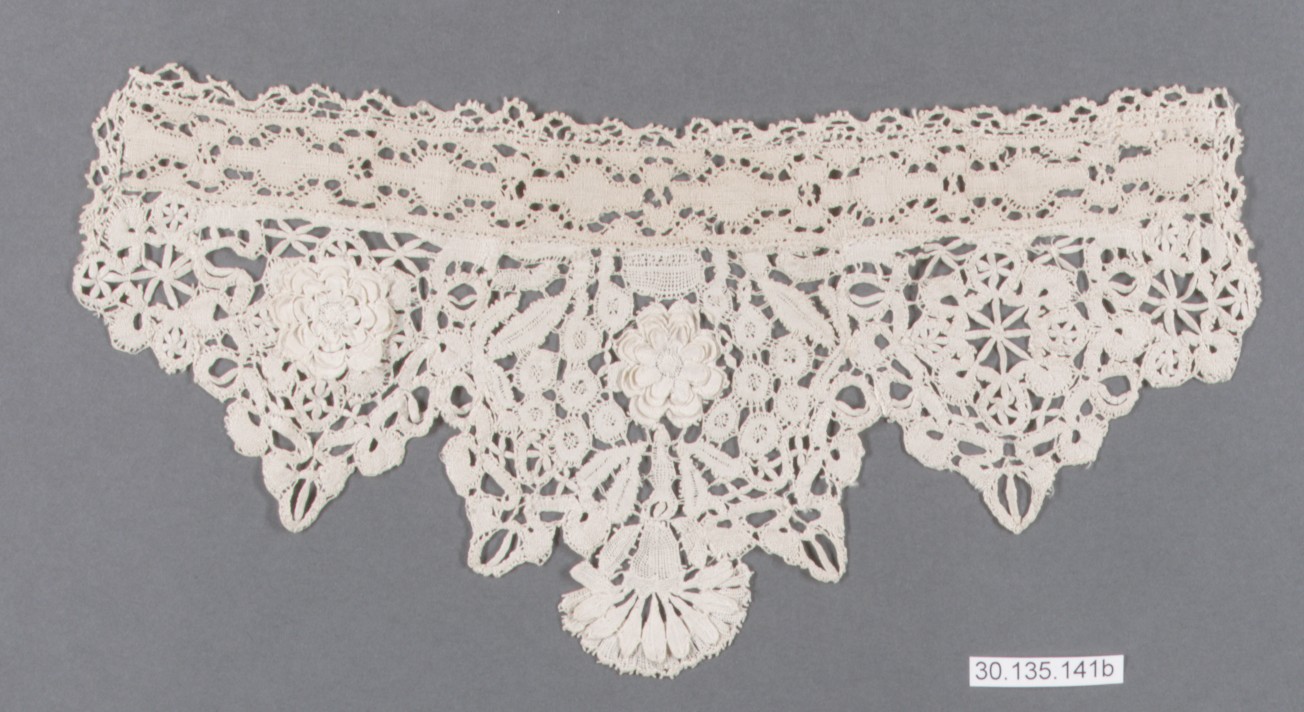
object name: cuff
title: Cuff (one of a pair)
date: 1850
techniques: lace